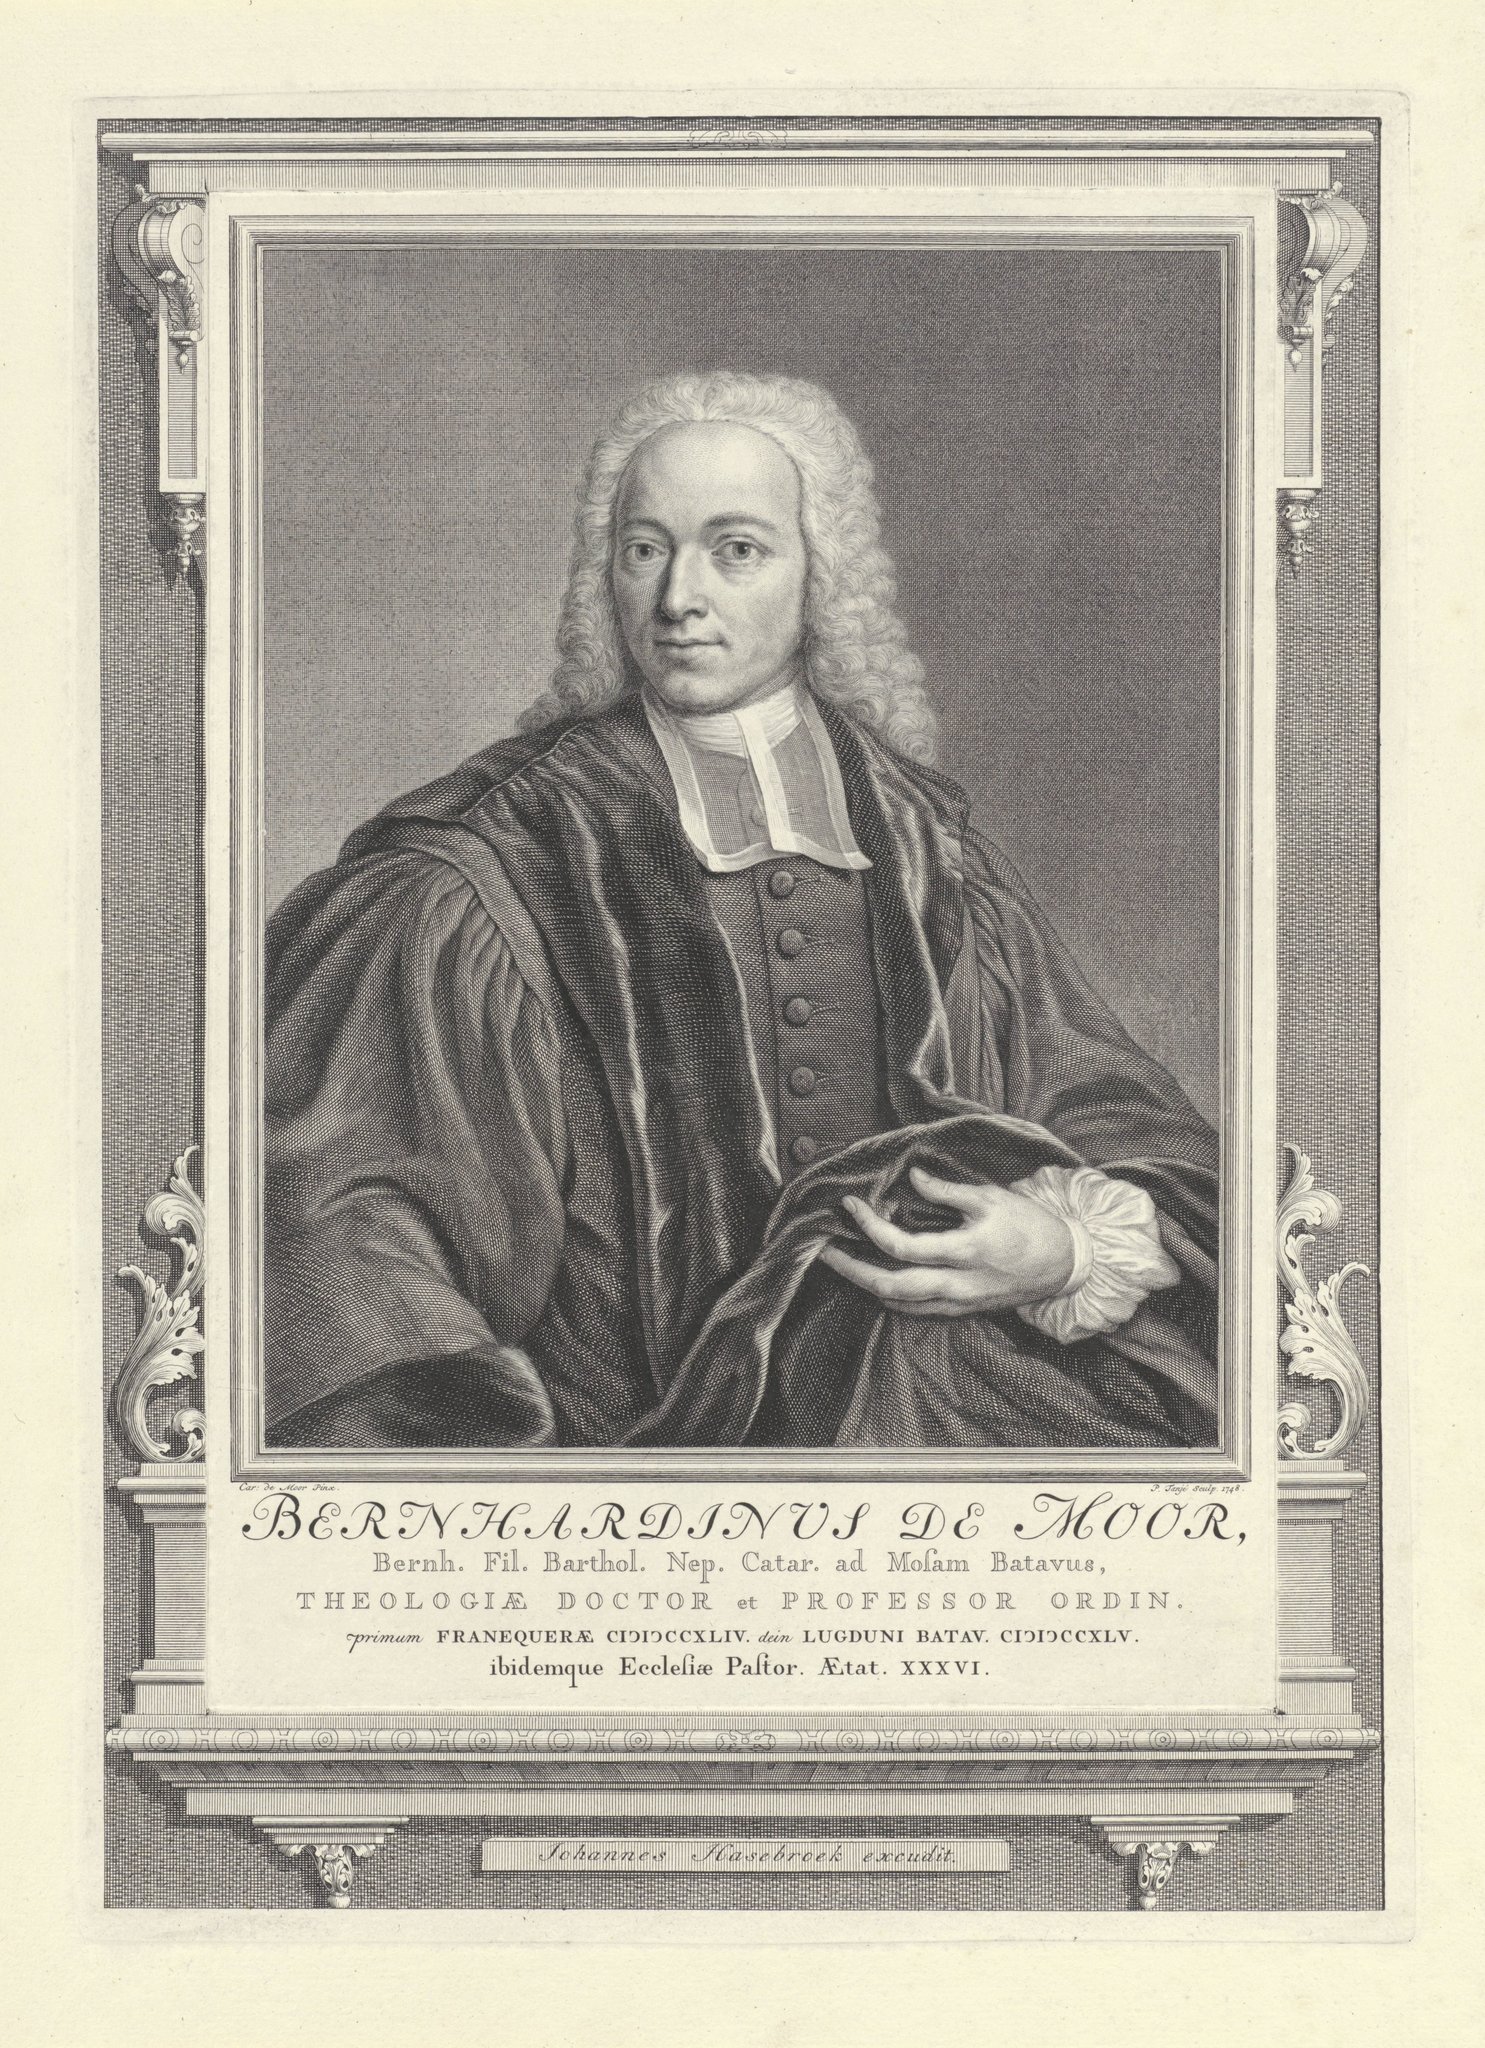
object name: print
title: Portret van Bernhardinus de Moor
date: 1748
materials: paper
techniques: engraving, etching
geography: amsterdam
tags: gouda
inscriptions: collector's mark: Lugt 240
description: Portret van Bernhardinus de Moor, predikant en hoogleraar in de theologie te Leiden. Het portret is gevat in een ornamentele lijst.